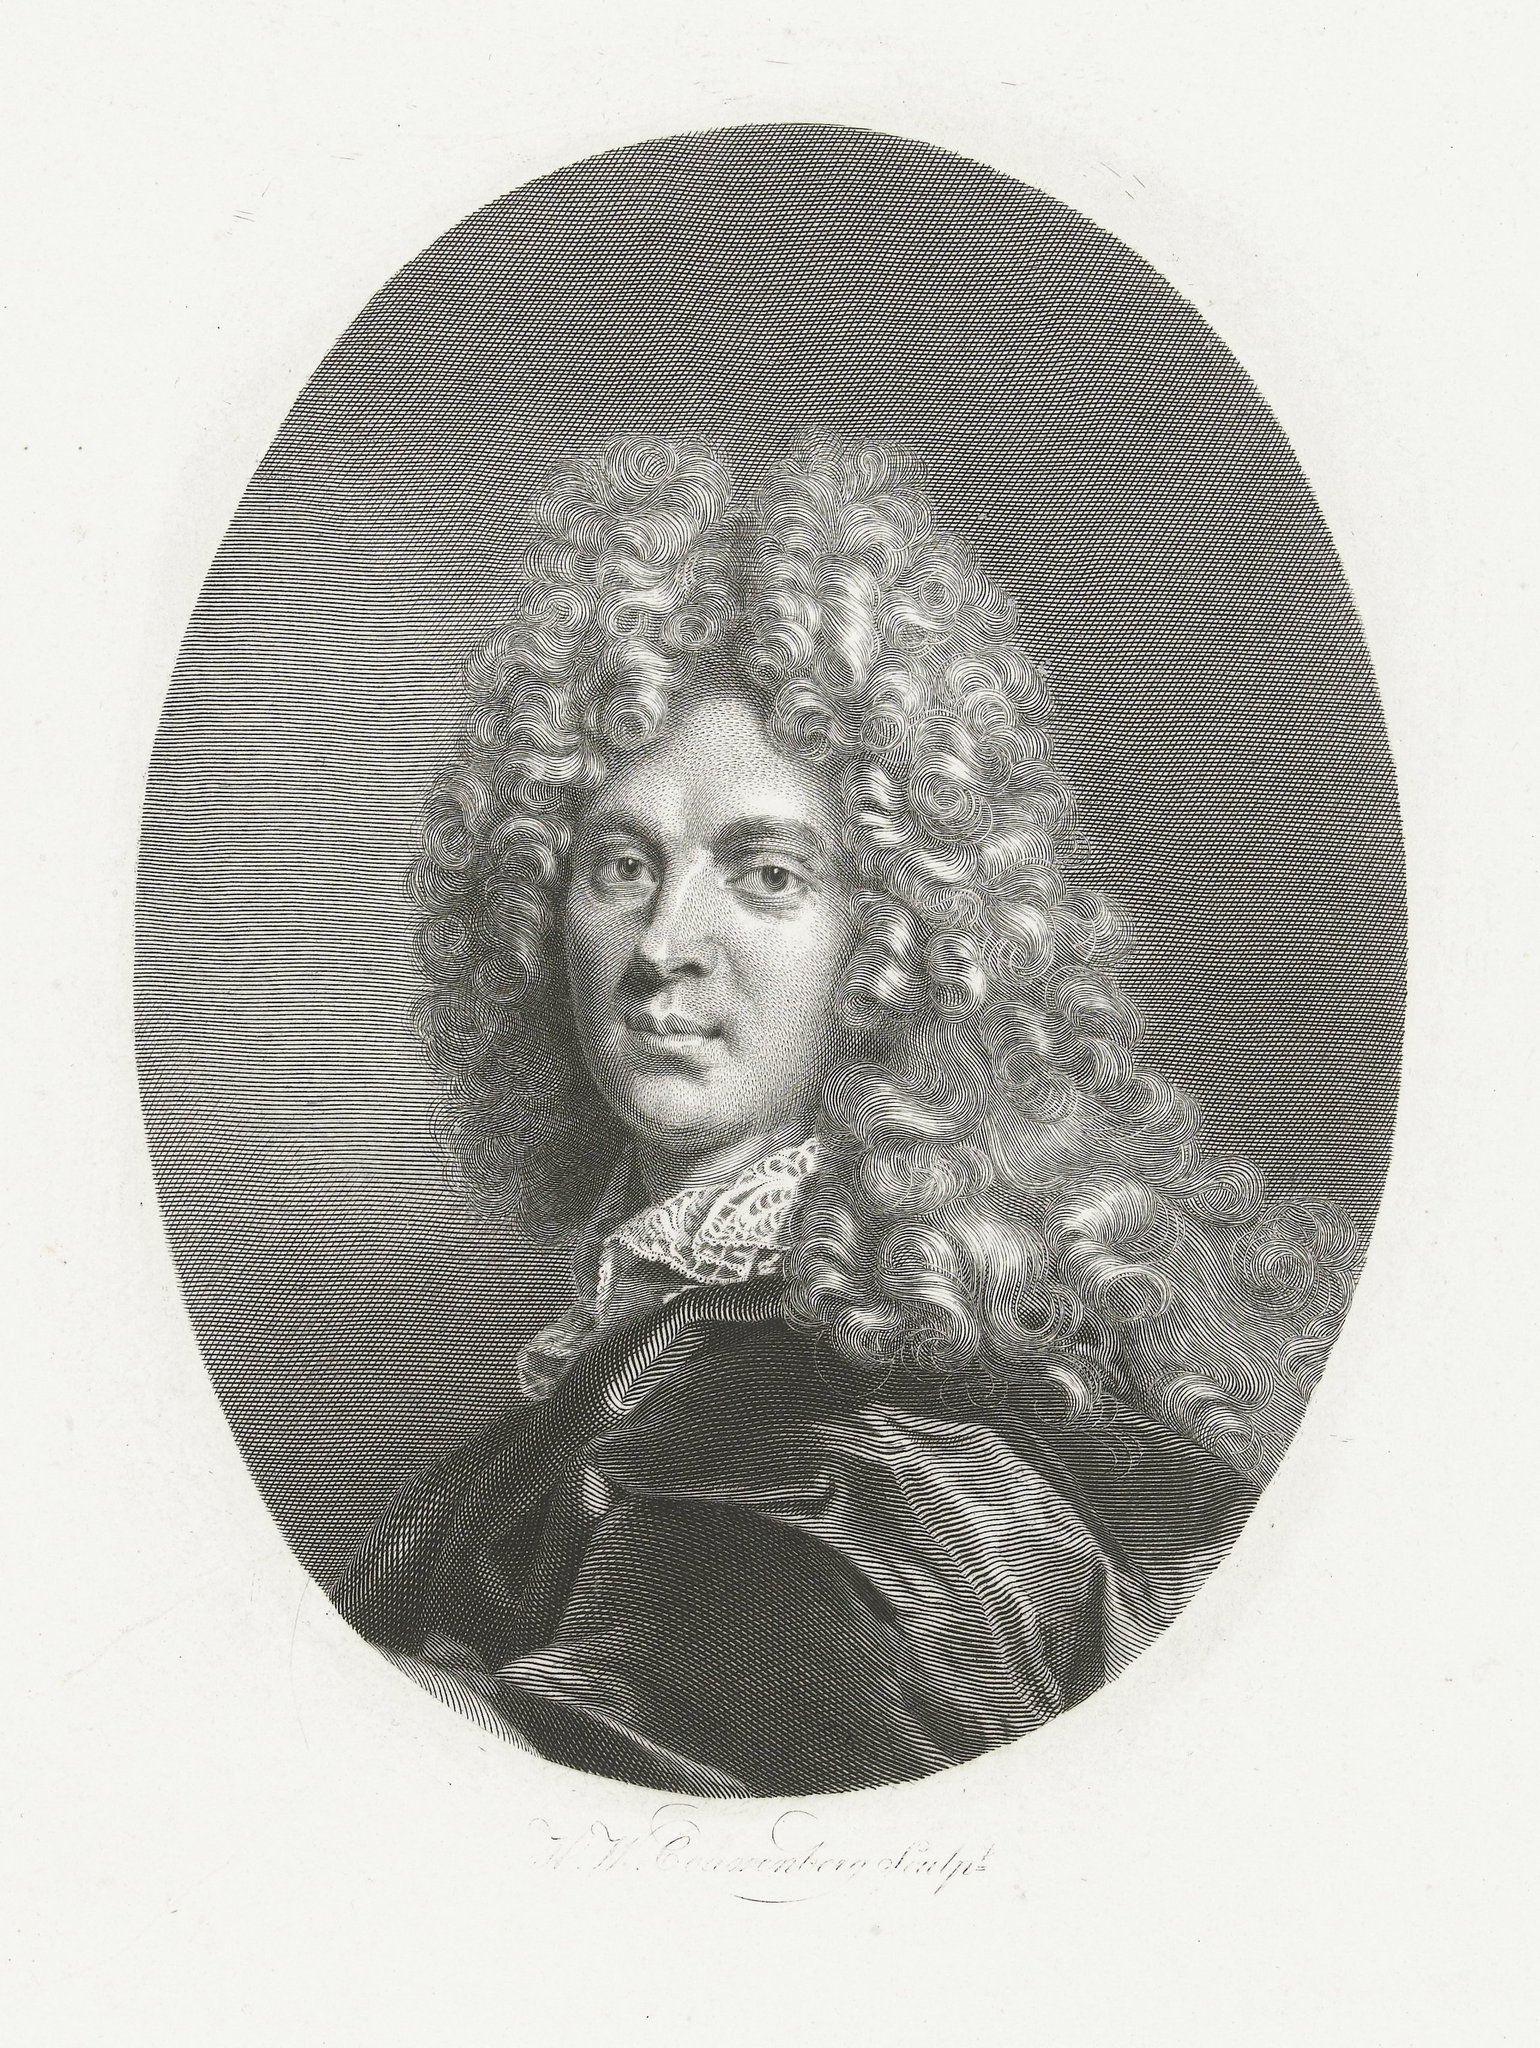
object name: print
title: Portret van Pierre-Vincent Bertin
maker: henricus wilhelmus couwenberg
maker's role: draughtsman, print maker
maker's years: 1814-1845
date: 1829-1845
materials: paper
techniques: engraving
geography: amsterdam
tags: reims, pierre vincent bertin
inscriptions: collector's mark: Lugt 2228